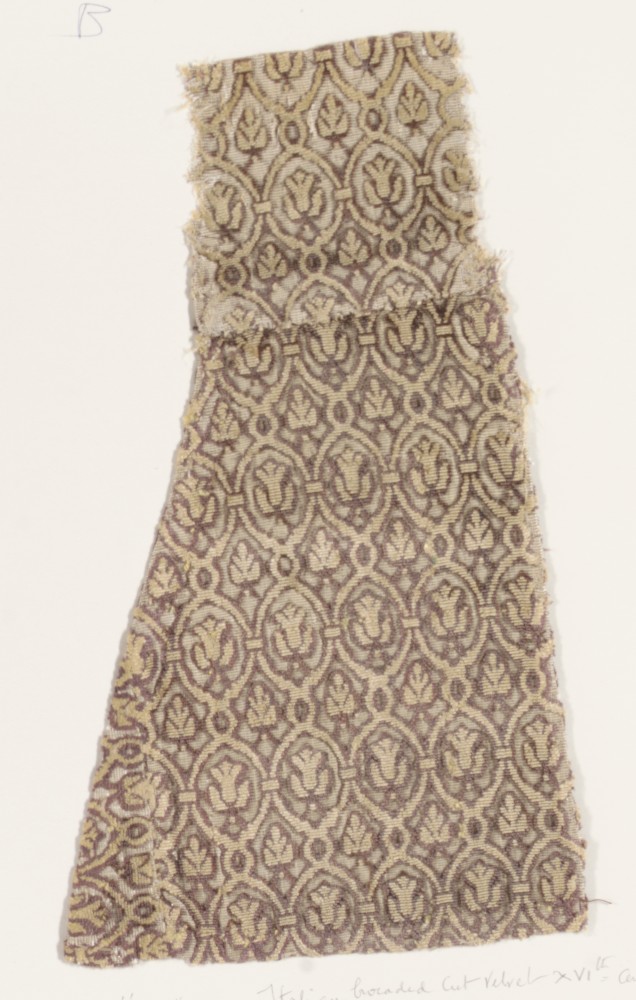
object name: fragment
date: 1501-1600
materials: metal thread, silk